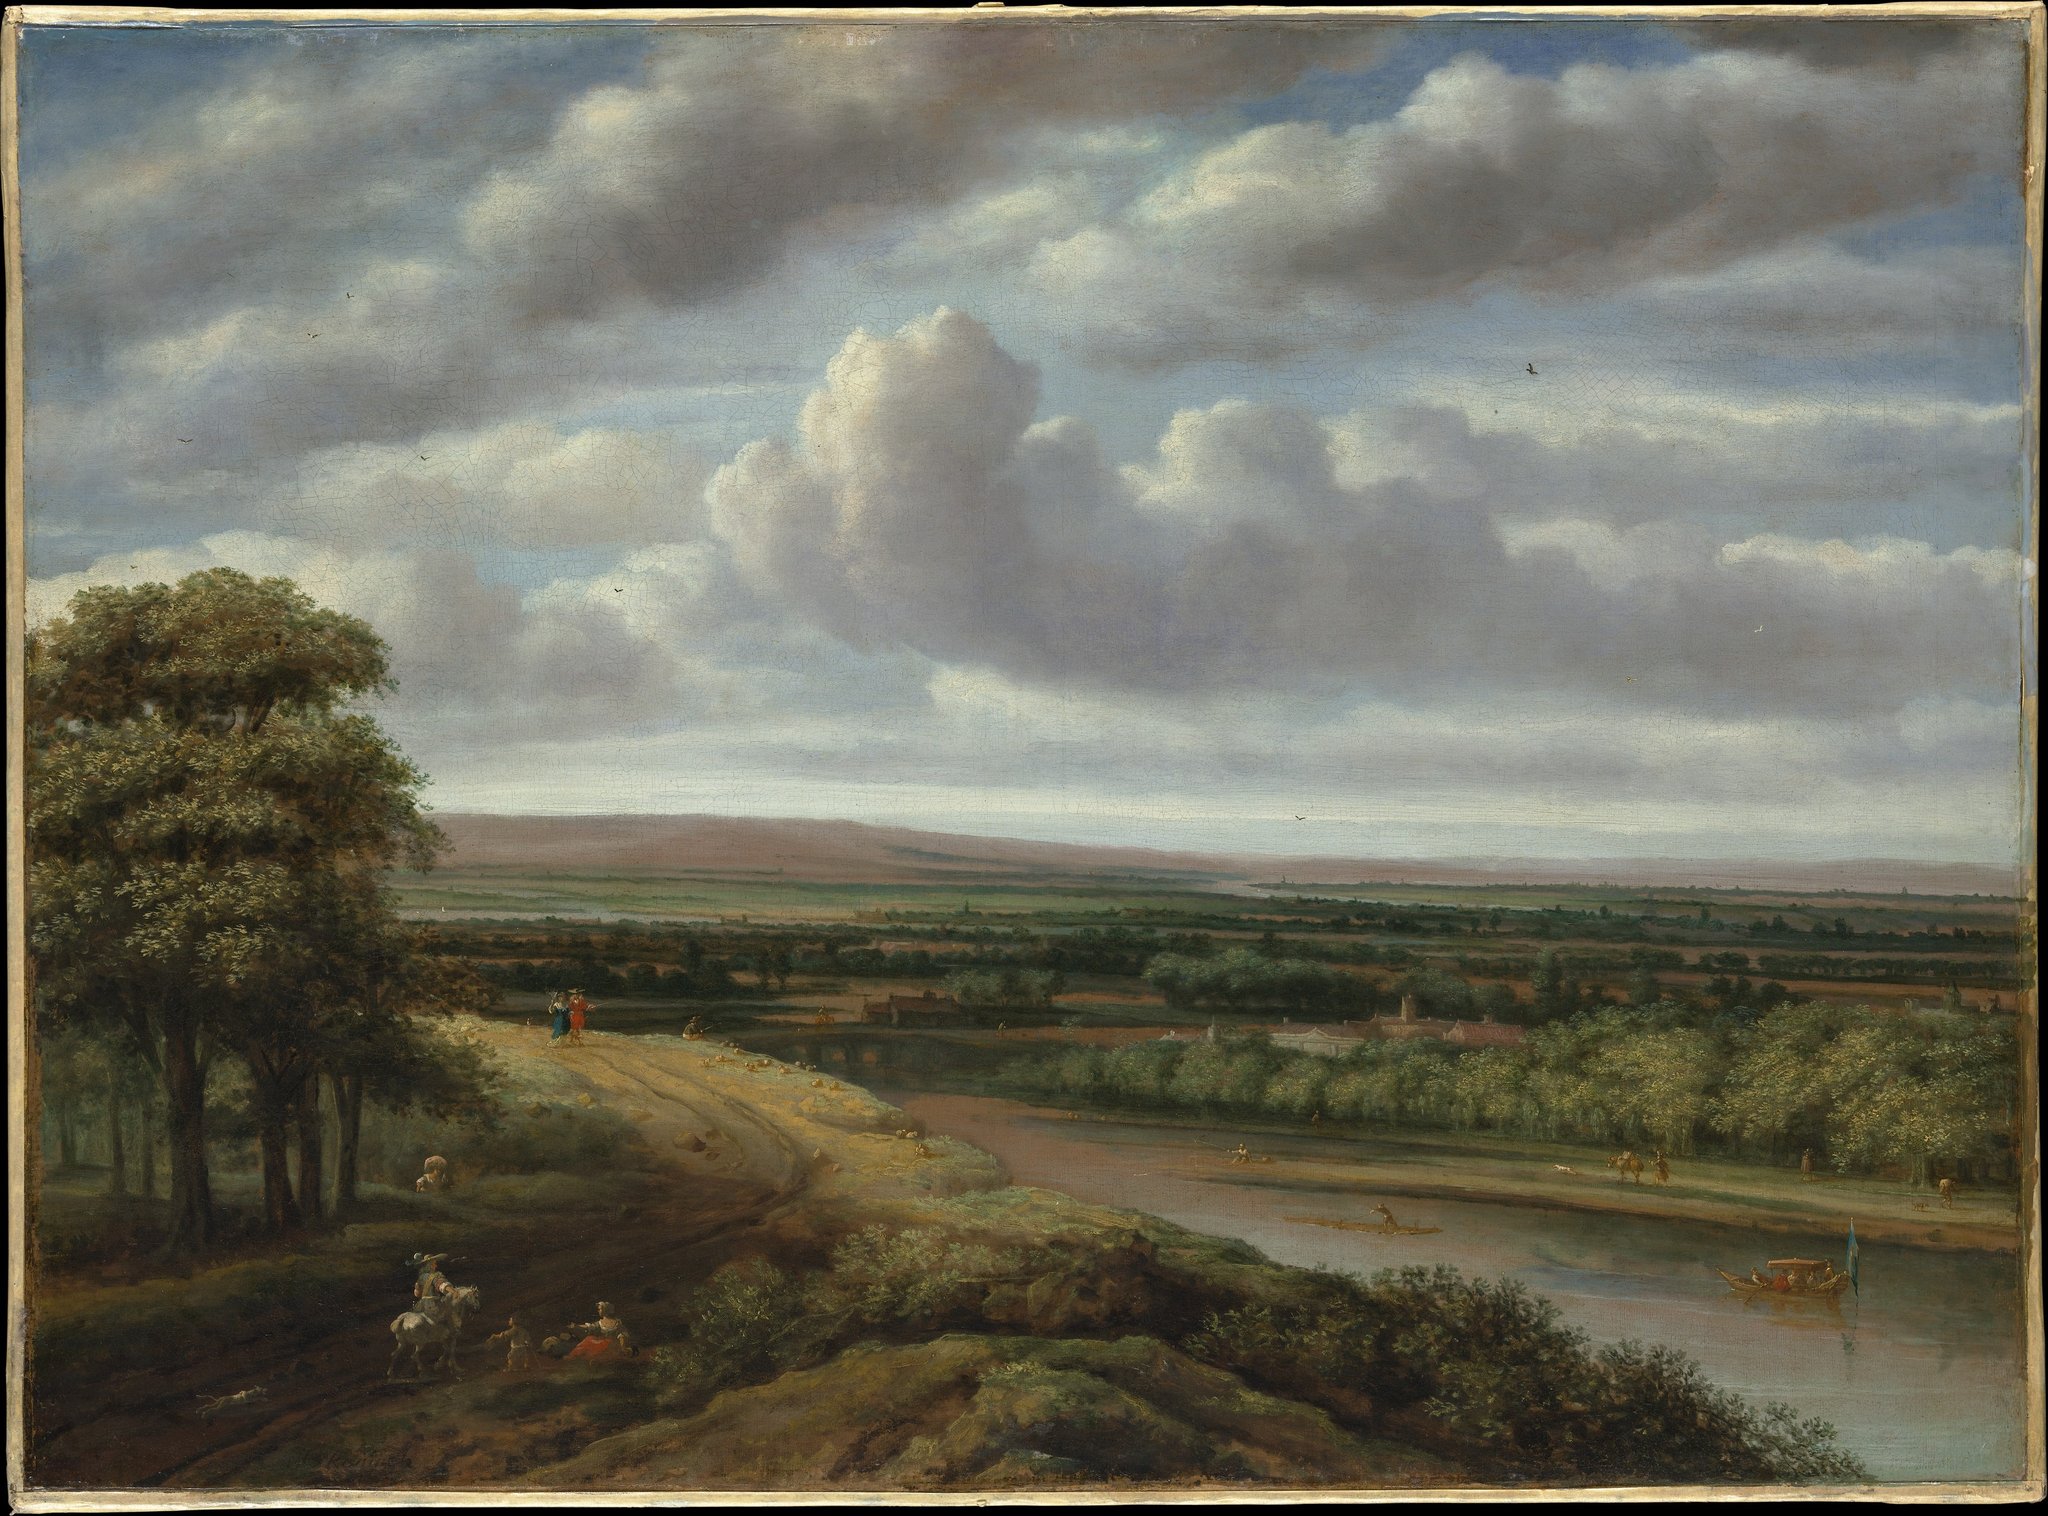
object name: painting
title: An Extensive Wooded Landscape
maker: philips koninck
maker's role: artist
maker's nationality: dutch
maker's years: 1619-1688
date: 1670-1679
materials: canvas, oil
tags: landscapes,clouds